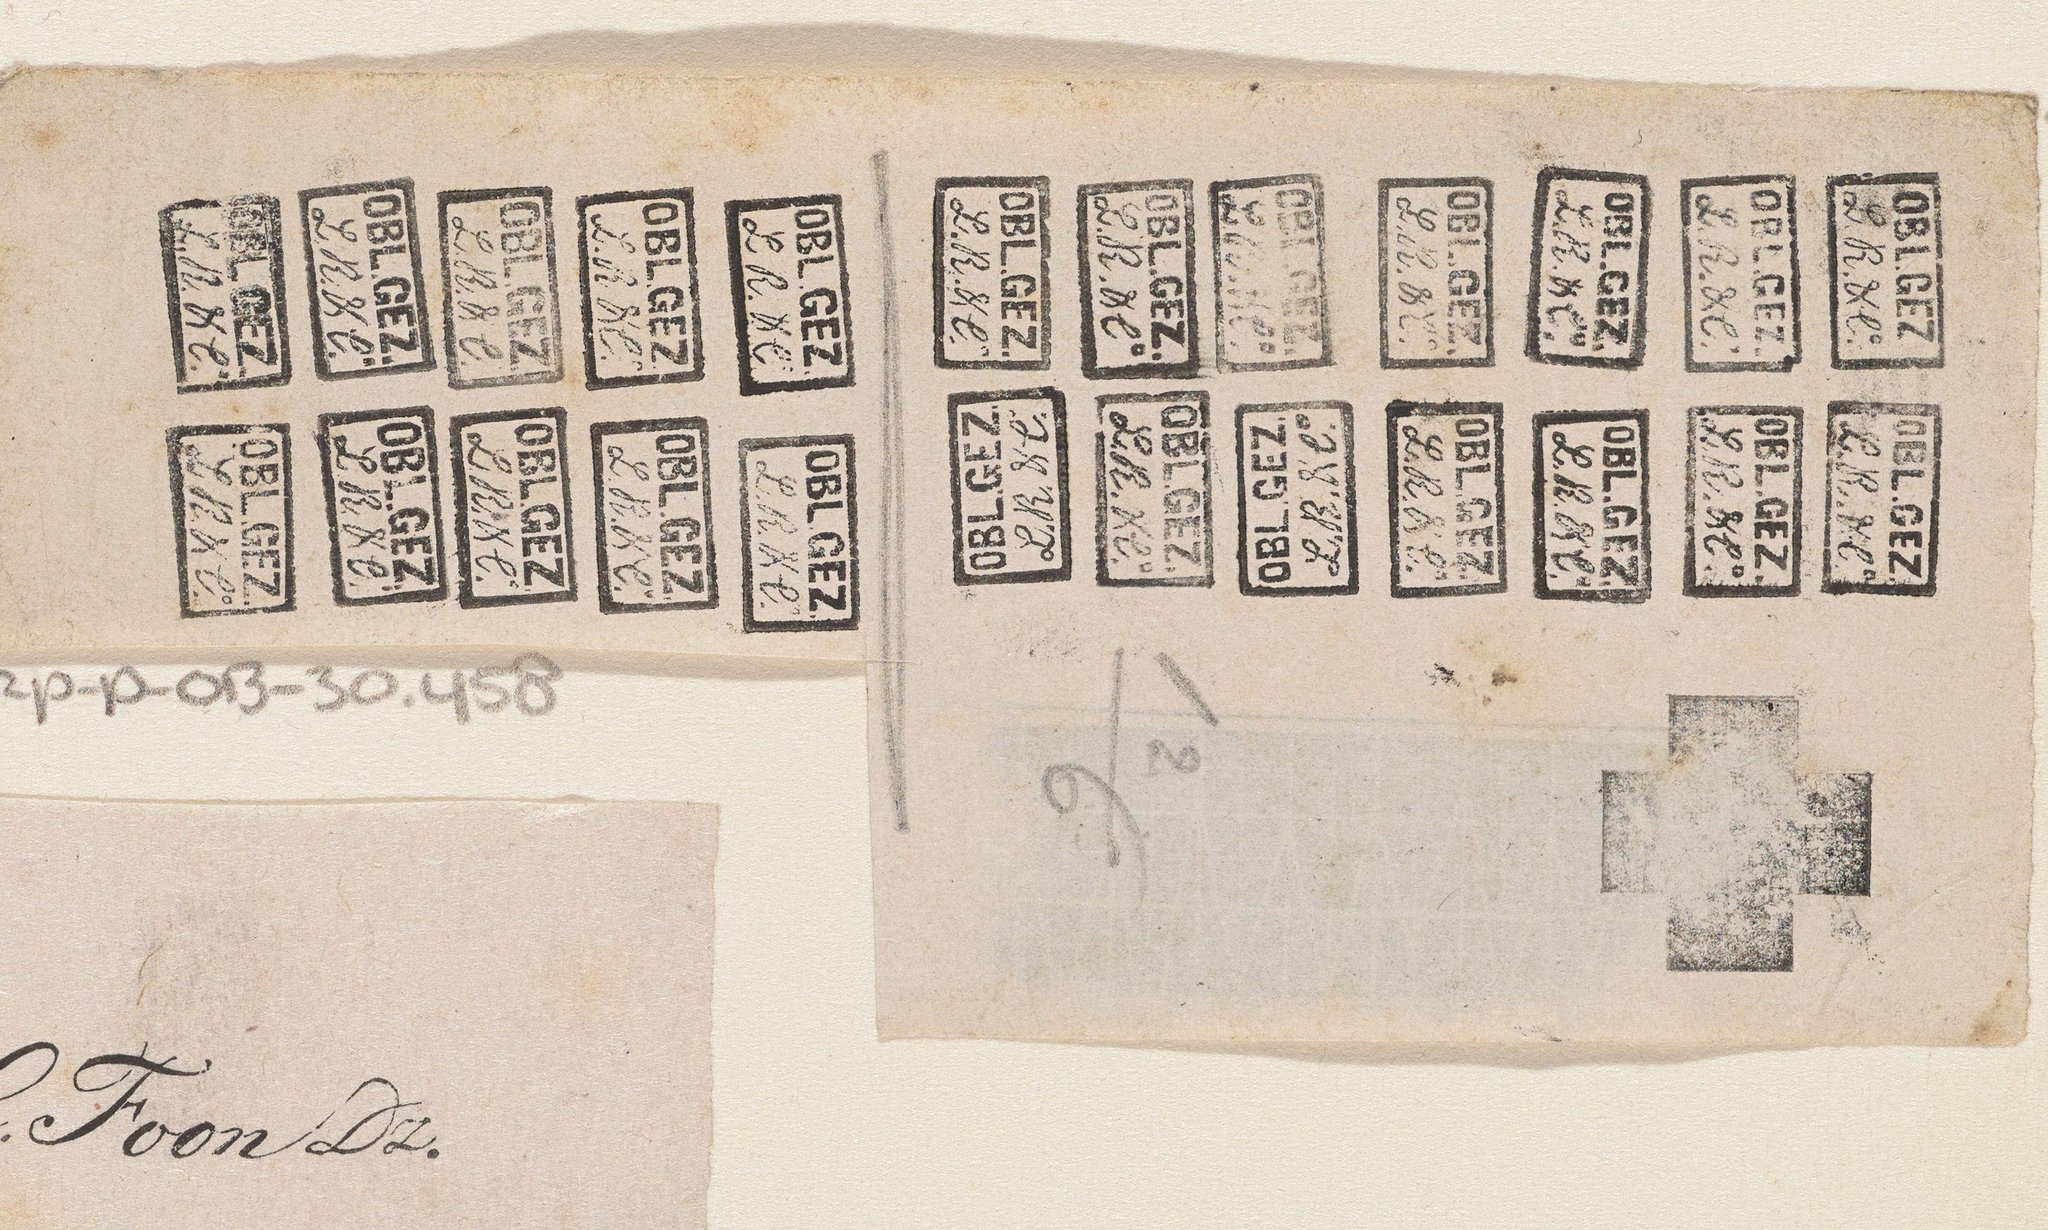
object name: print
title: 24 merken van de bank Lippmann, Rosenthal & Comp. te Amsterdam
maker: isaac weissenbruch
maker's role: print maker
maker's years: 1826-1912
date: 1859-1912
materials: paper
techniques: engraving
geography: netherlands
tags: bank